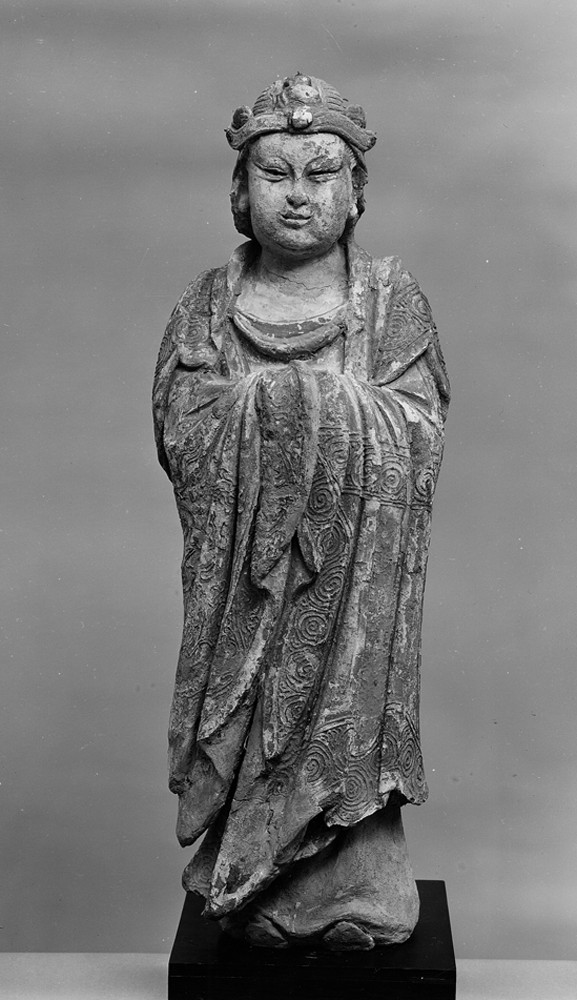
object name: figure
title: Bodhisattva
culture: chinese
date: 901-1000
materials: clay, pigment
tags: human figures